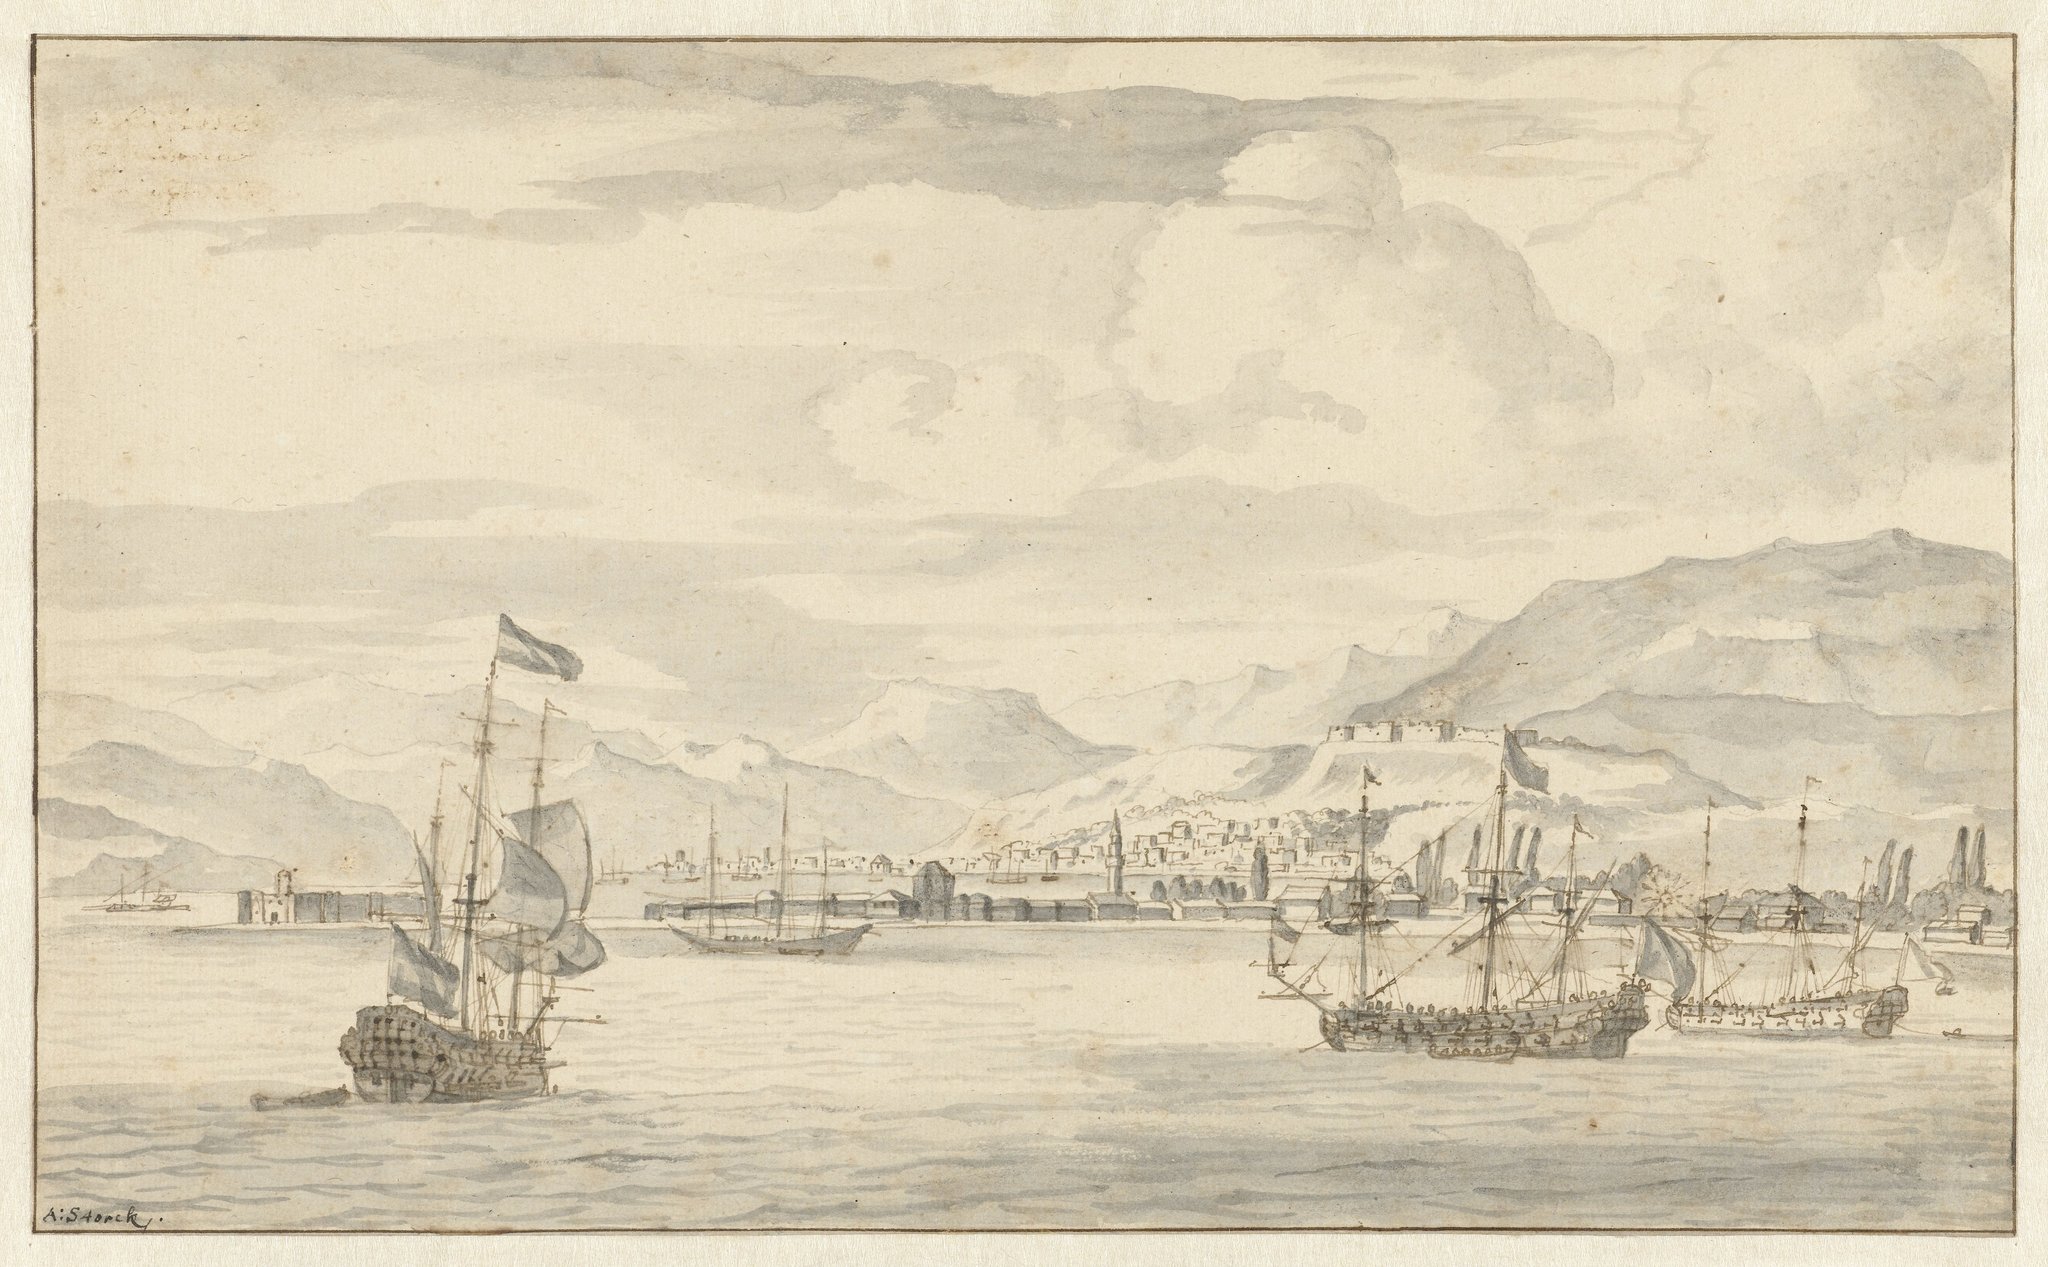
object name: drawing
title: Gezicht op Smyrna (Izmir)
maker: abraham storck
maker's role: draughtsman, painter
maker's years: 1644-1708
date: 1645-1710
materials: chalk, graphite, ink, paper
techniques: brush, pen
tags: harbour, sailing-ship, sailing-boat, coast